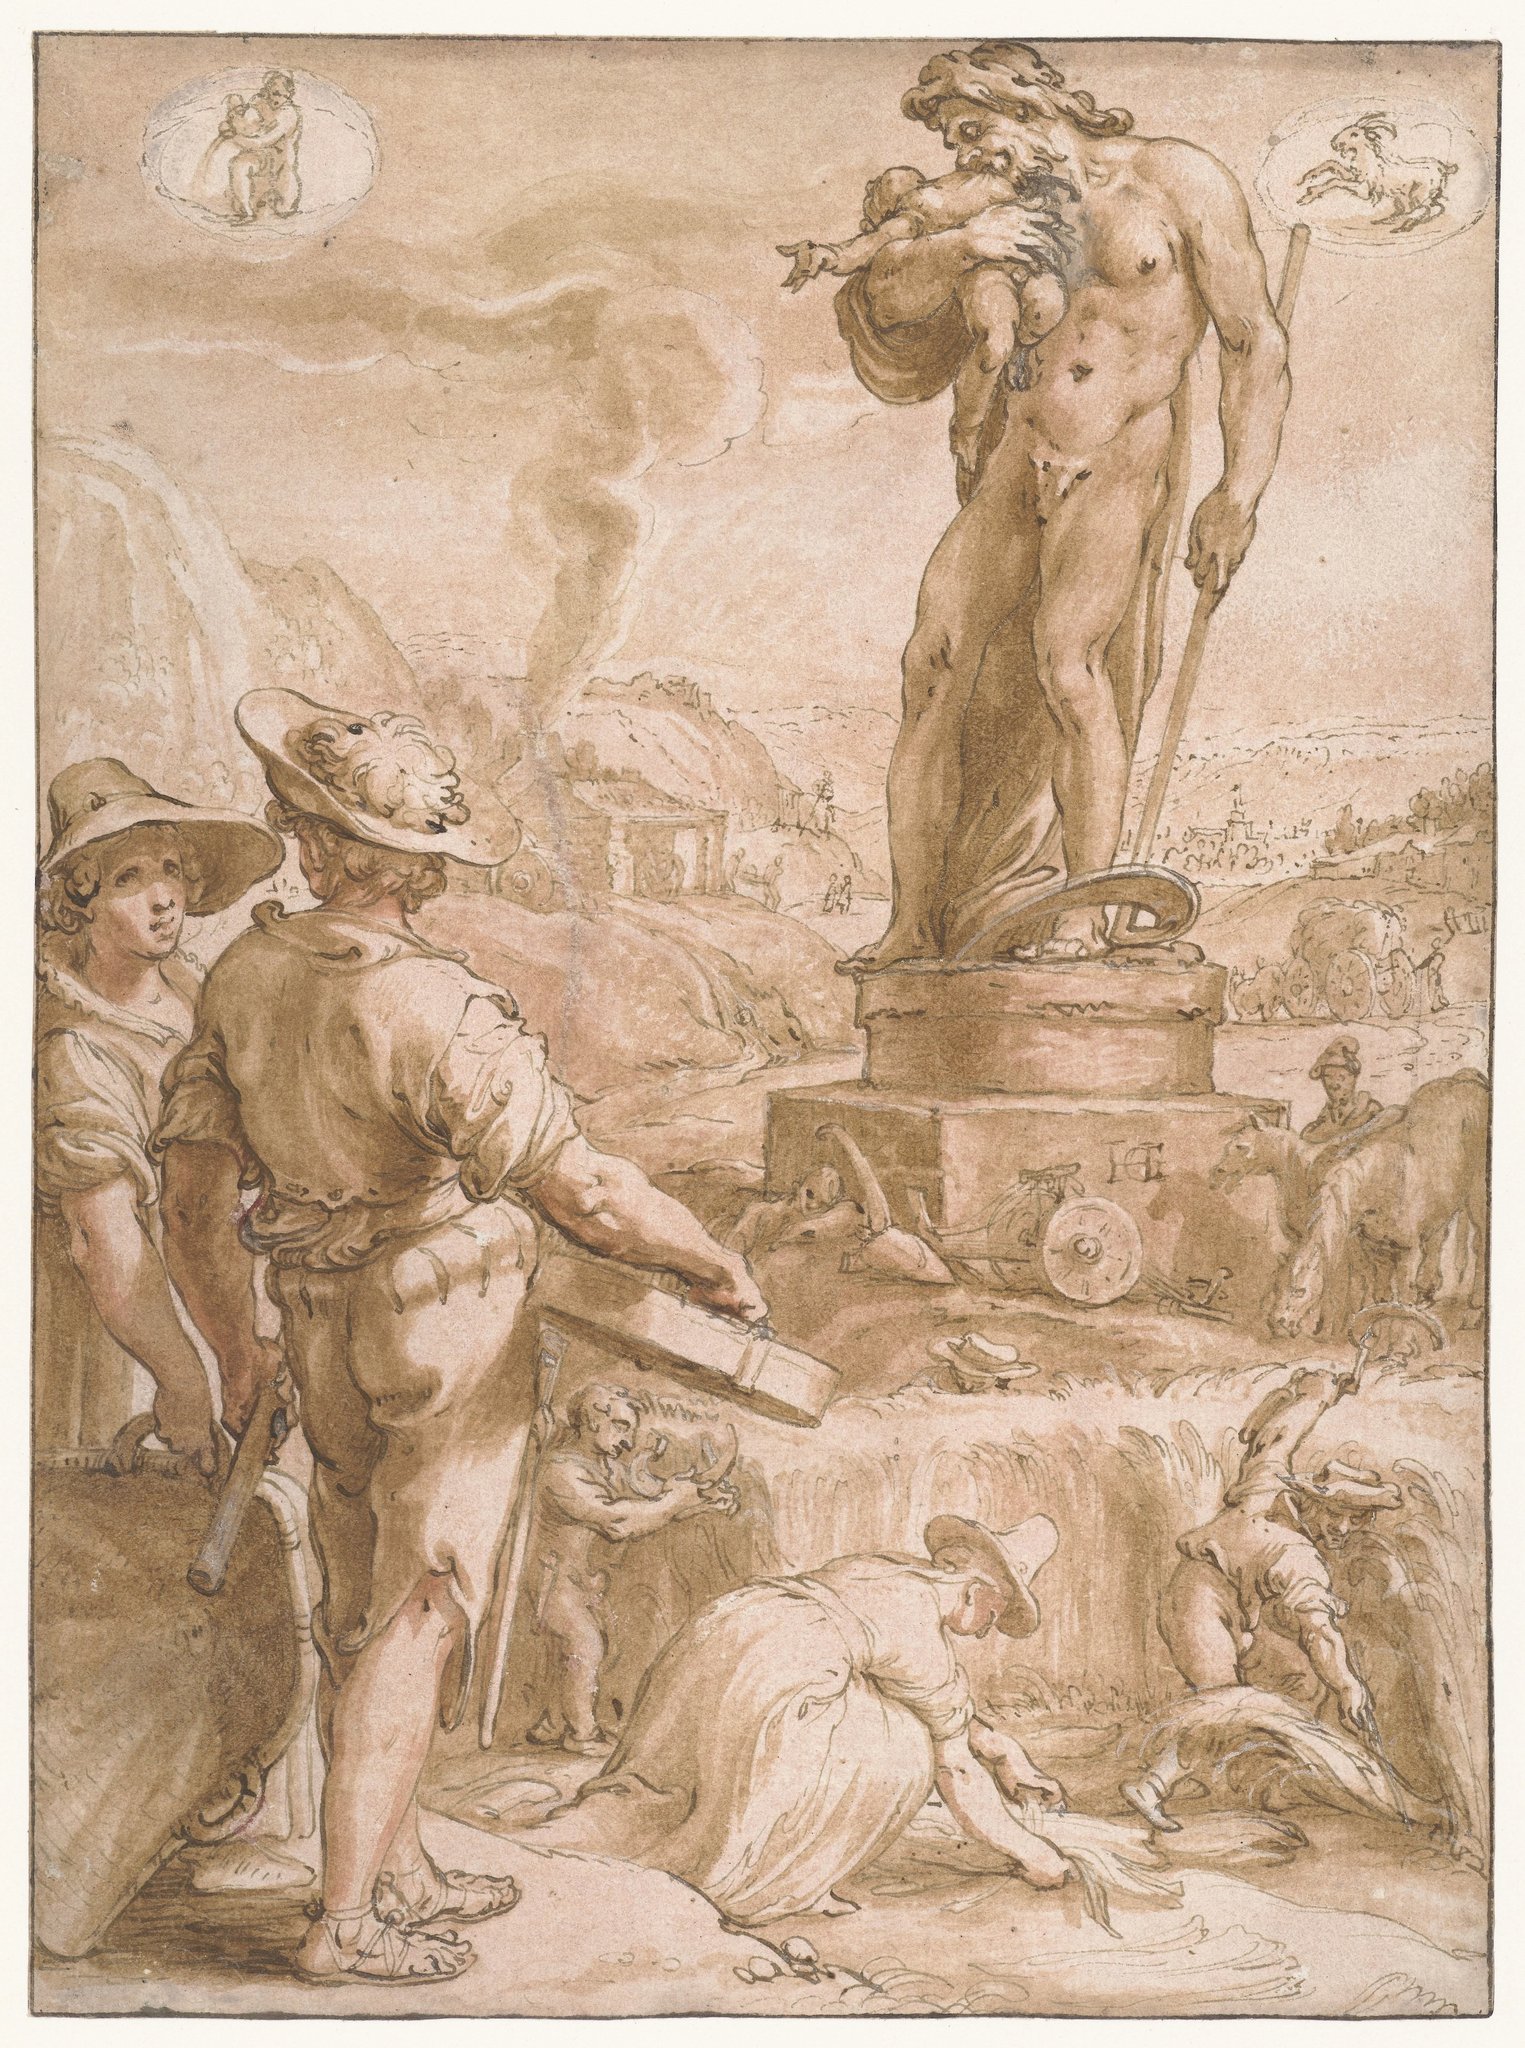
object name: drawing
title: Zeven planeten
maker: hendrick goltzius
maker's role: draughtsman, painter, print maker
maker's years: 1558-1617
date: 1591-1596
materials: ink, paper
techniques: brush, pen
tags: harvest, saturn and his children ('planetenkinder') ~ aquarius and capricorn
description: Gegraveerd voor de series de Zeven Planeten door J.Saenredam met het onderschrift: 'Aurea me quondam terris regnante fuerunt Tempora, sponte sua quaevis tellure ferrente C. Schonaeus'. De gravure is gedateerd 1569, waarschijnlijk een fout gemaakt door de graveur, het moet zijn 1596. De twee andere tekeningen uit de Burgy veiling zijn nu in het Prentenkabinet der Rijkuniversiteit Leiden.